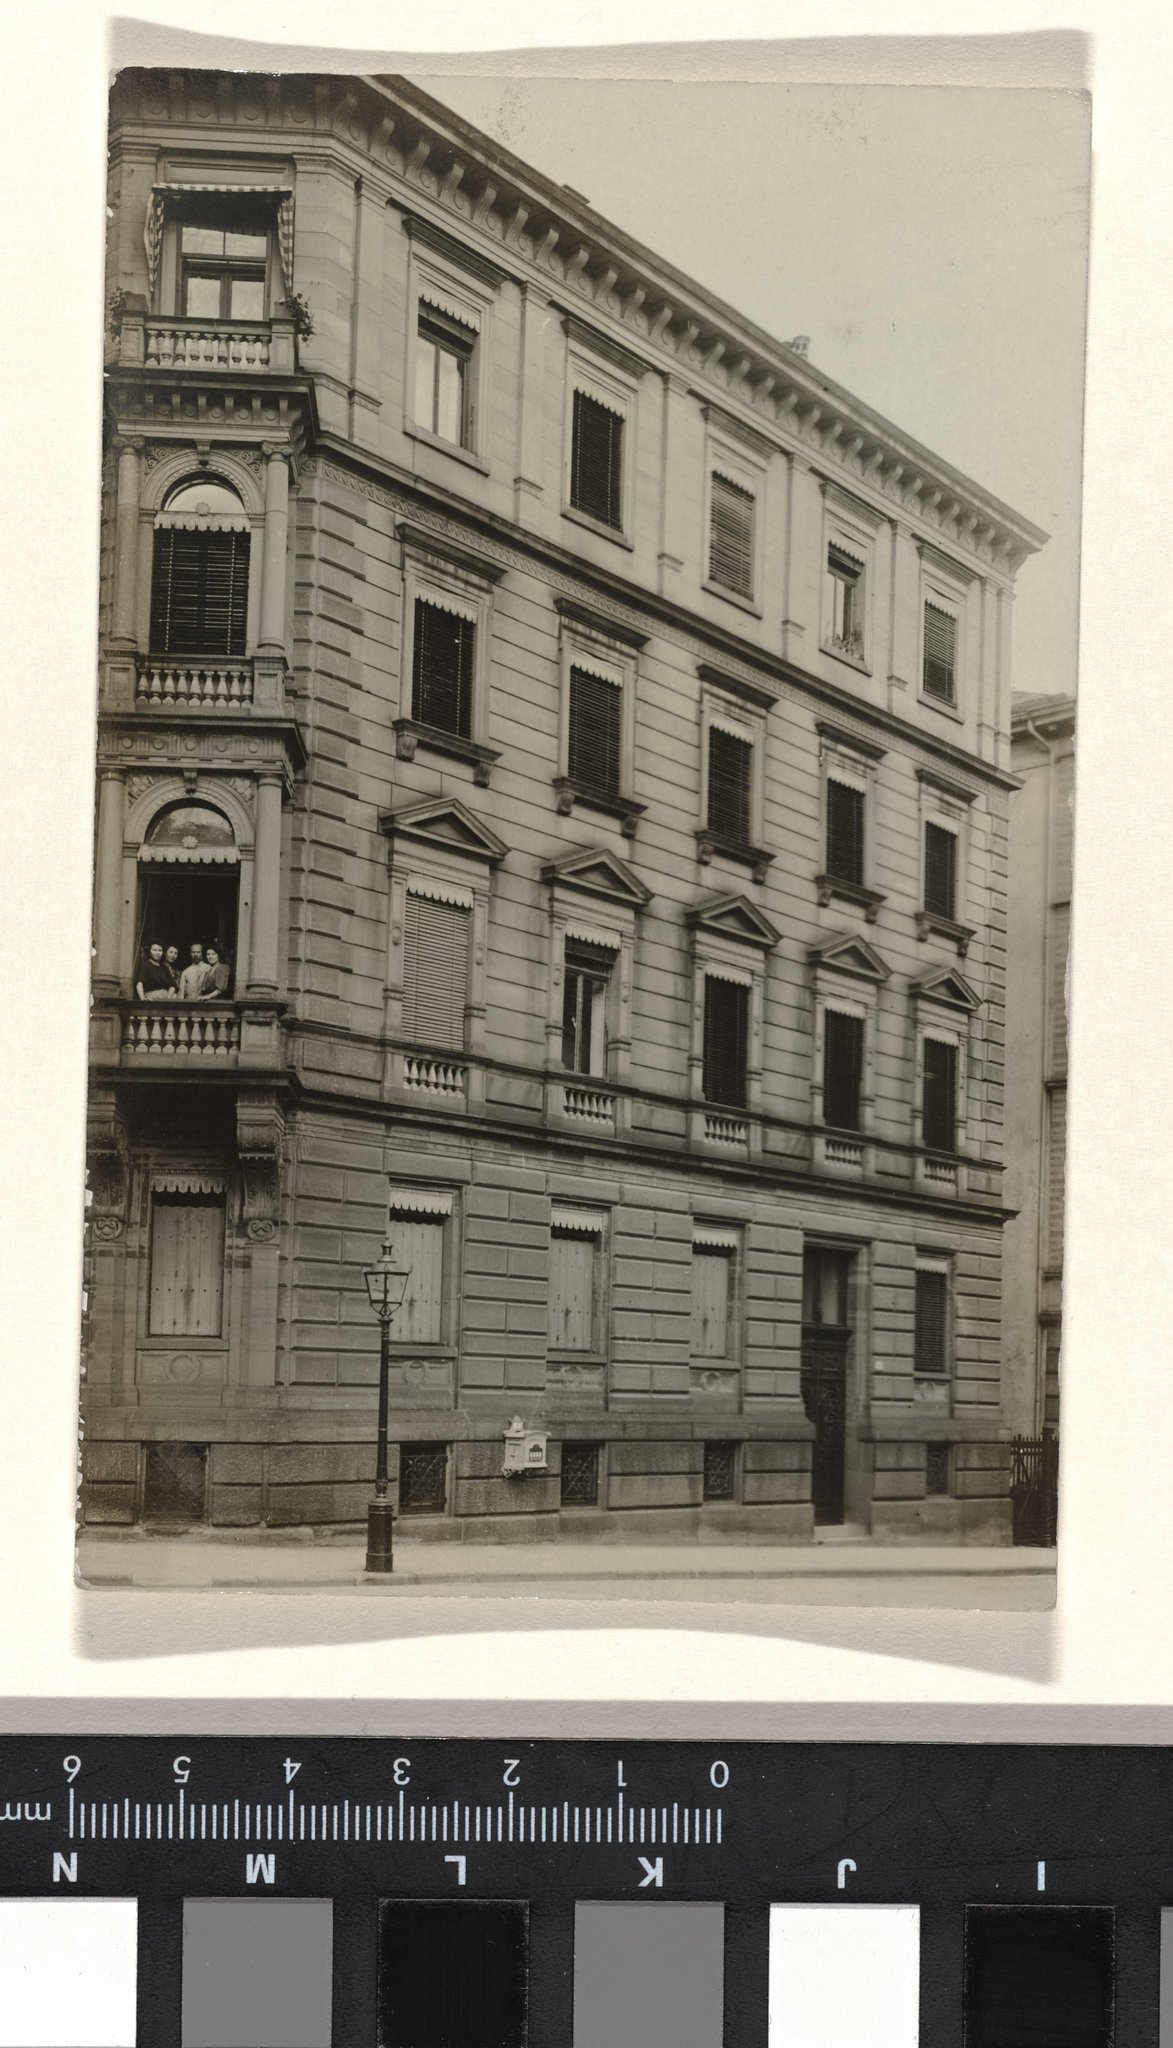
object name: photograph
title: Zij aanzicht van een flatgebouw, met daarin vier onbekende mensen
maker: Anonymous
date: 1890-1930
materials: photographic support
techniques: gelatin silver print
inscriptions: inscription: ‘früheren Heim ...’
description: Zij aanzicht van een flatgebouw, met daarin vier onbekende mensen.